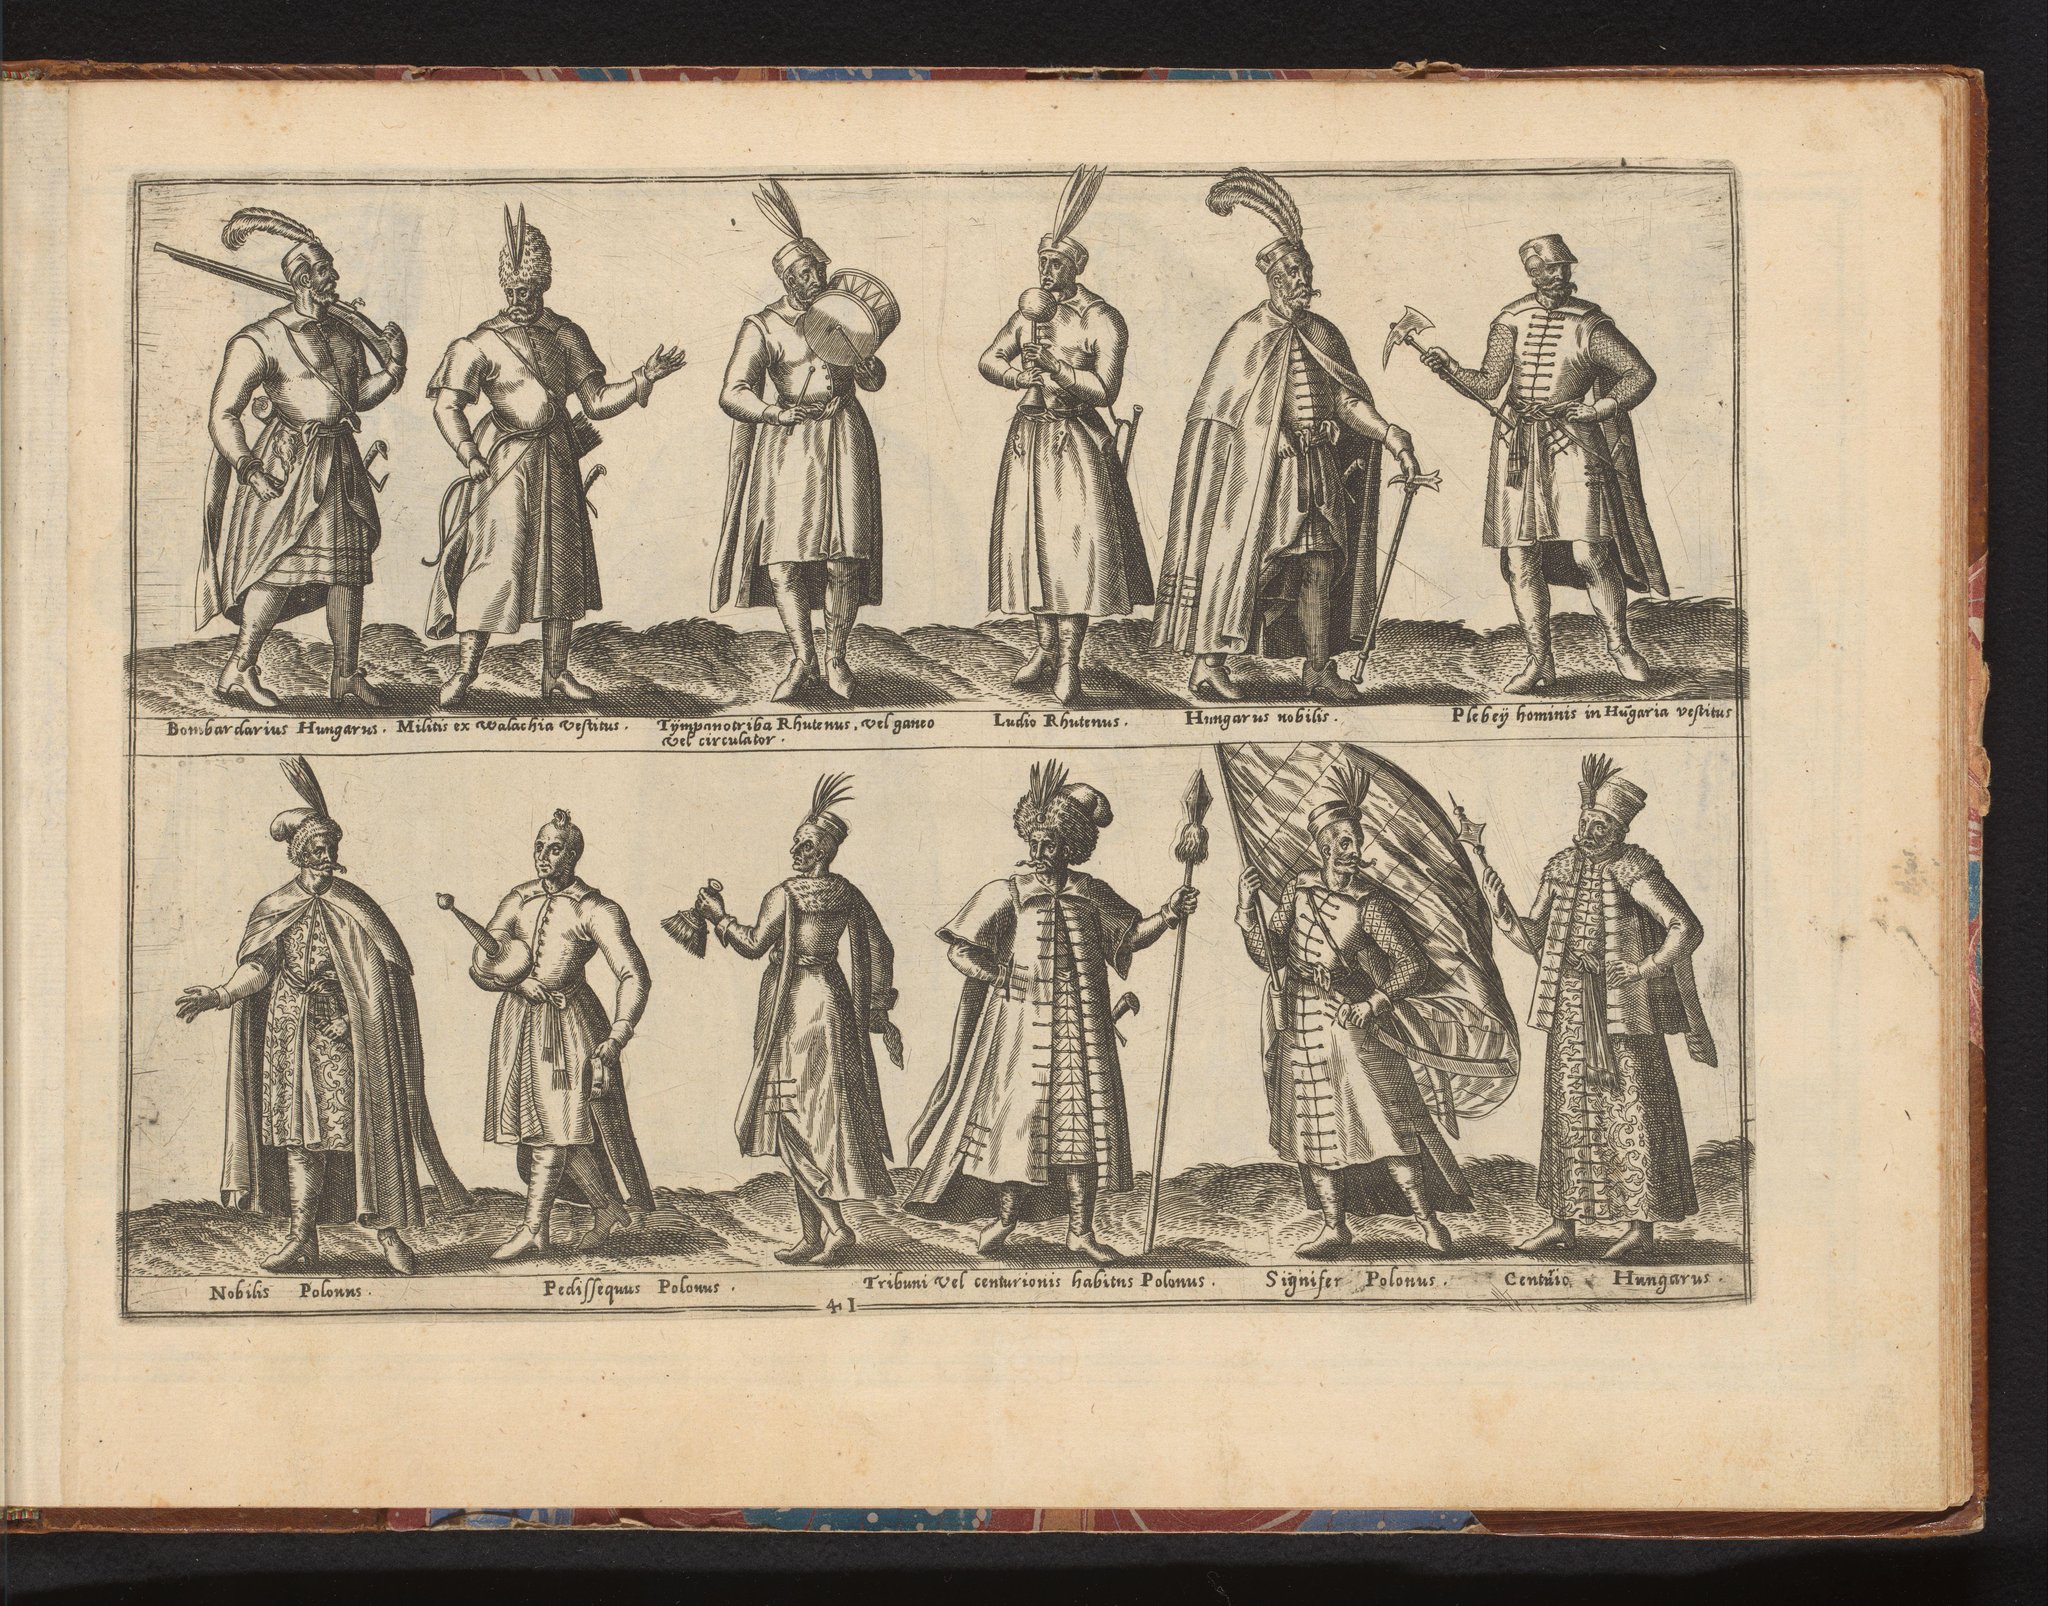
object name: album leaf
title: Twaalf Polen en Hongaren, gekleed volgens de mode van ca. 1580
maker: abraham de bruyn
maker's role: print maker, publisher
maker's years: 1540-1587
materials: paper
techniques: engraving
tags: europeans (with name) (+ costume), europeans (polish) (+ costume), clothes, costume (+ men's clothes)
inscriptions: number: ‘41’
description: In twee rijen boven elkaar. Prent uit het boek 'Omnium pene Europae, Asiae, Aphricae atque Americae gentium habitus...', 1581. De prent maakt deel uit van een album.